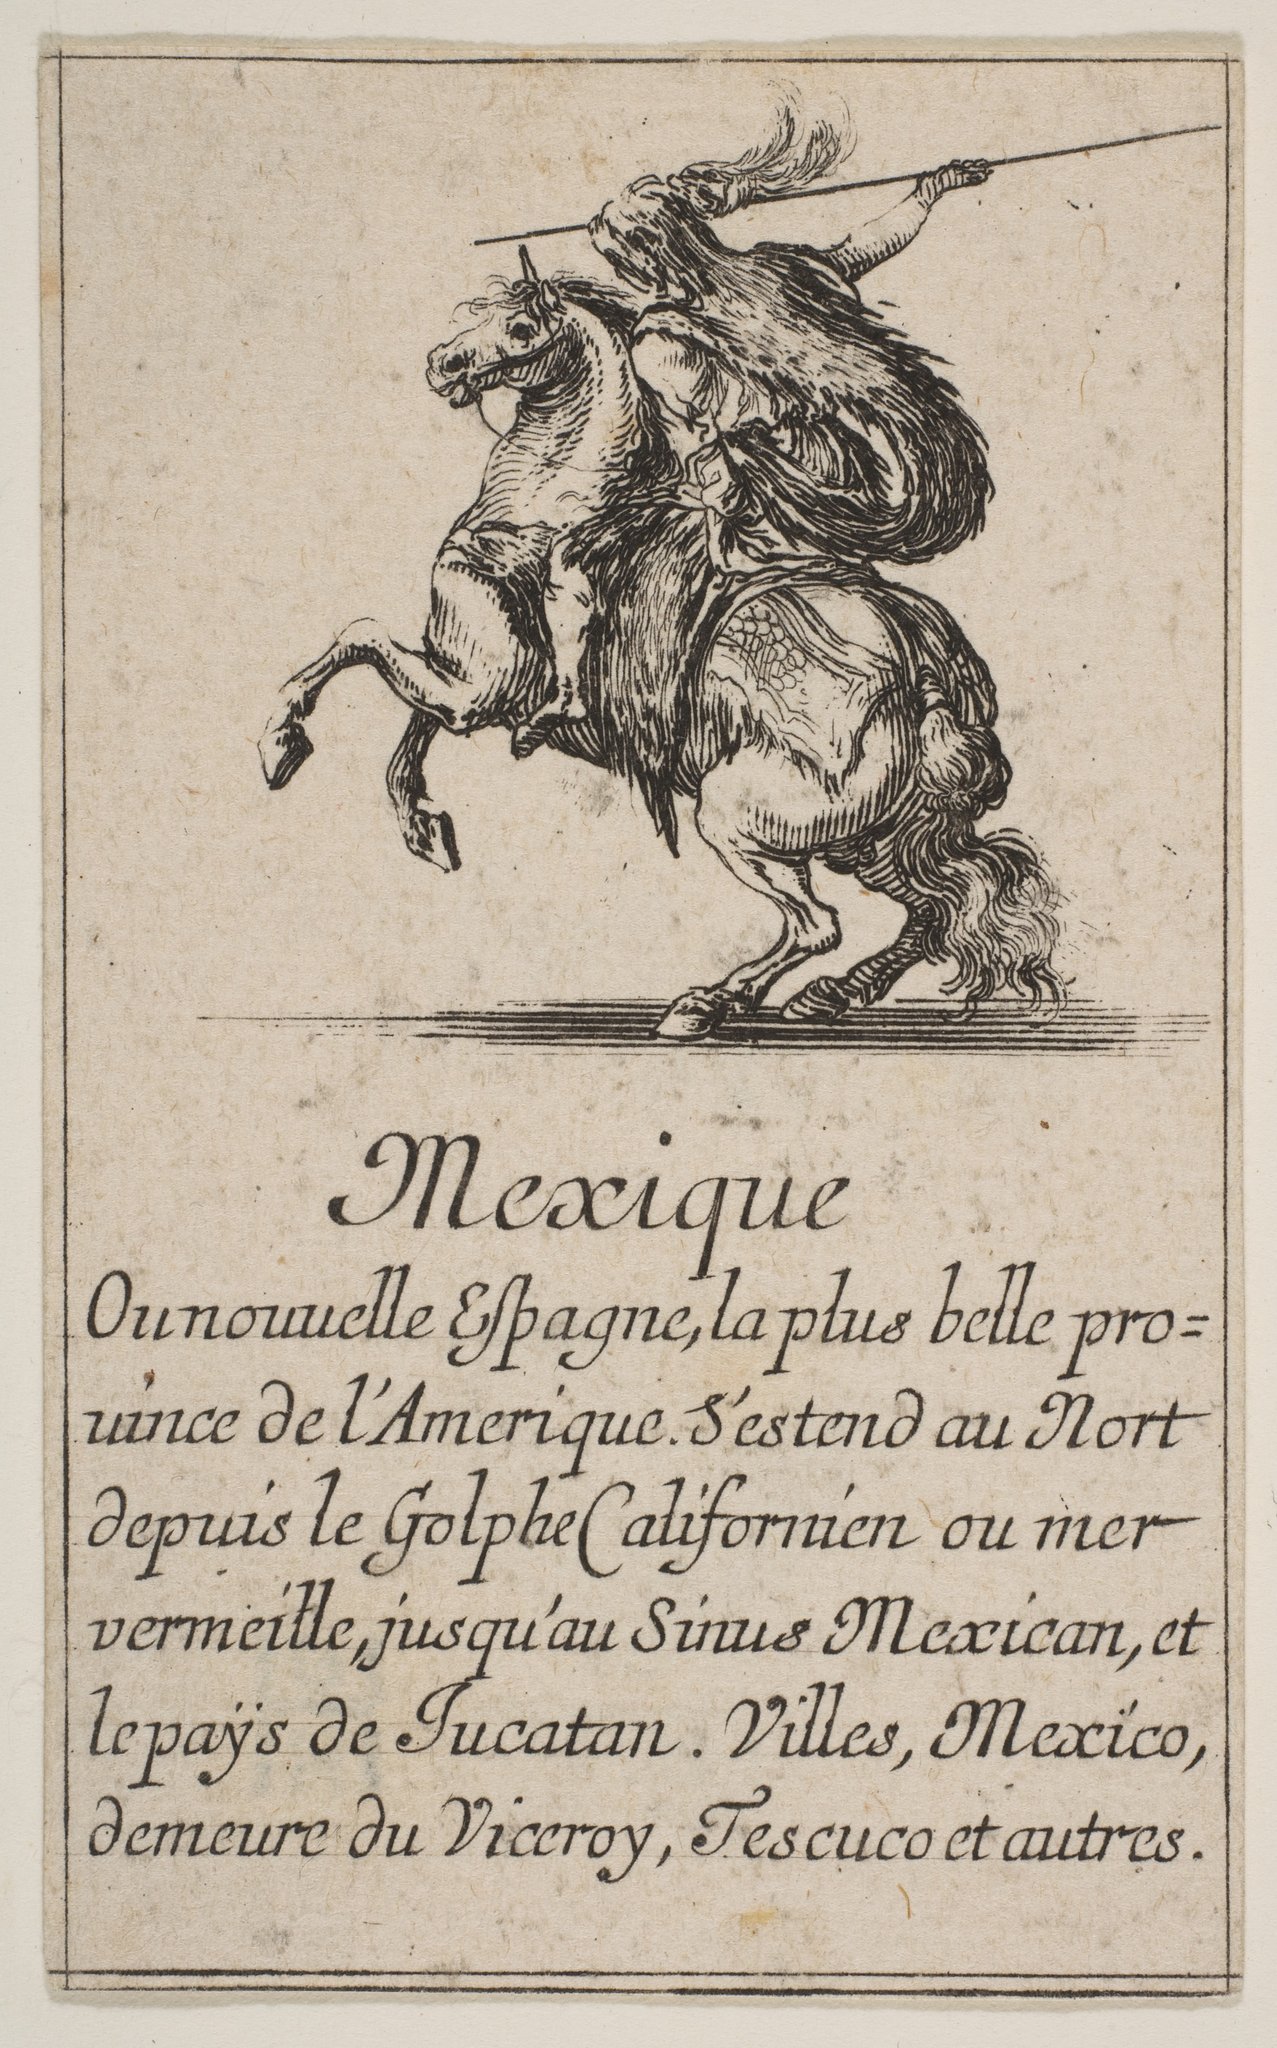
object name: print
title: Mexico, from the playing cards "Jeu de la Géographie"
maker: stefano della bella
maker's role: artist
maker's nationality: italian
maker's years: 1610-1664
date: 1644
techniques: etching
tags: human figures,weapons,horses